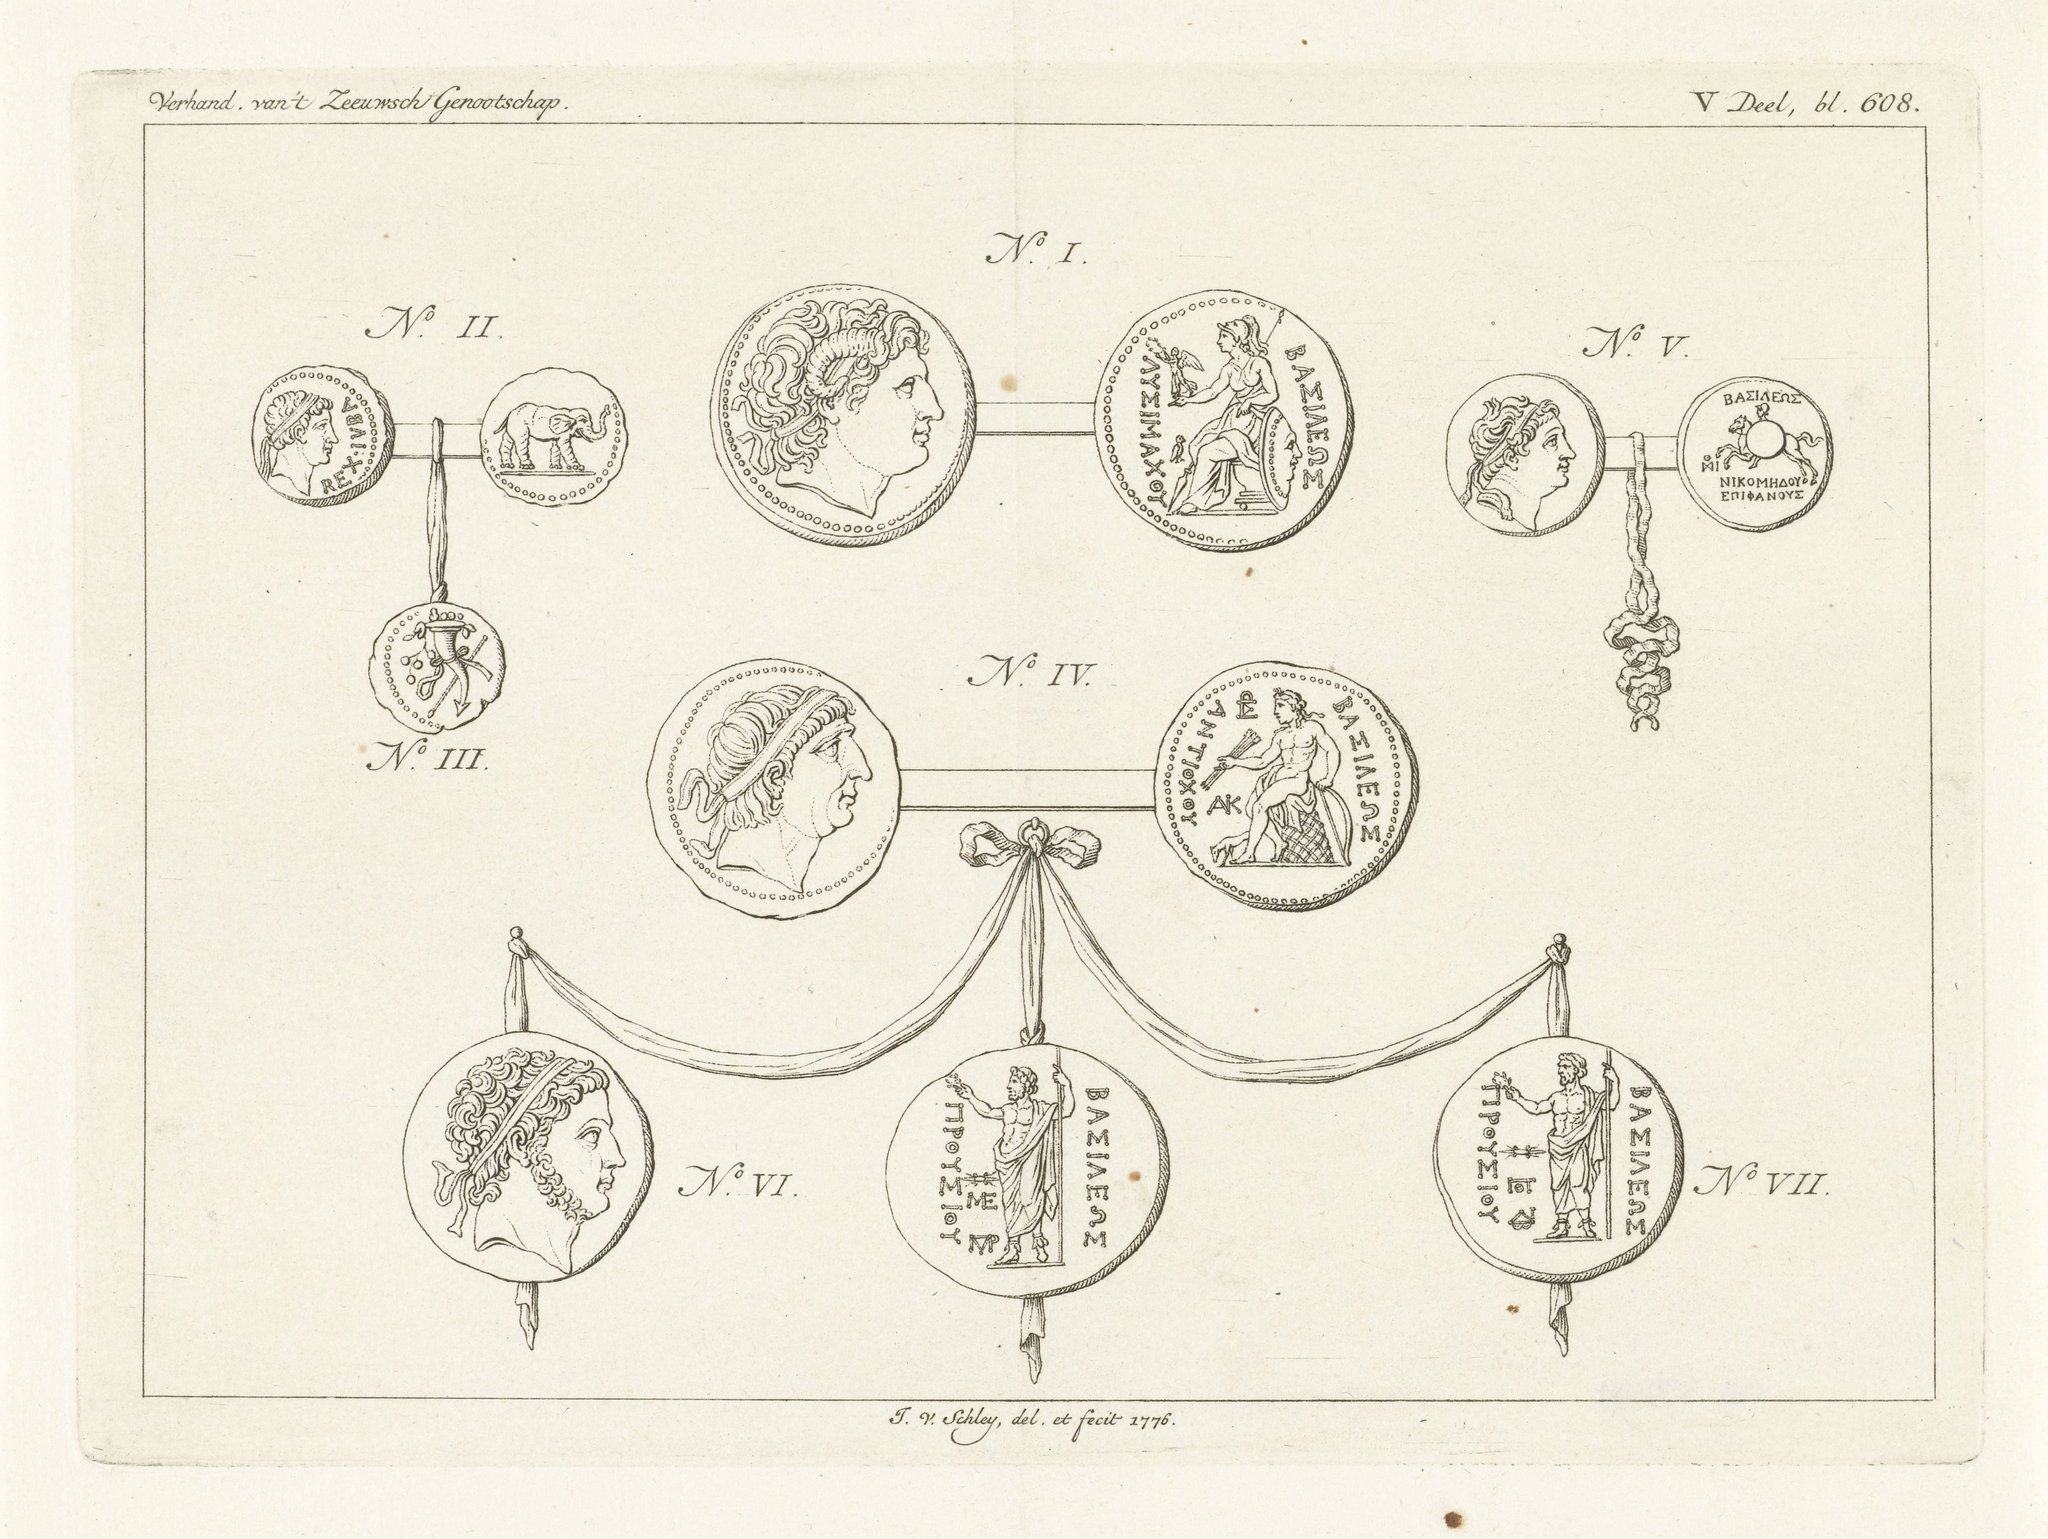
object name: print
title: Griekse munten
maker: jacob van der schley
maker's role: draughtsman, print maker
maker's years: 1715-1779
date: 1776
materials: paper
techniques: etching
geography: amsterdam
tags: coin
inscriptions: date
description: Voor- en achterzijde van zeven Griekse munten, genummerd 1-7.